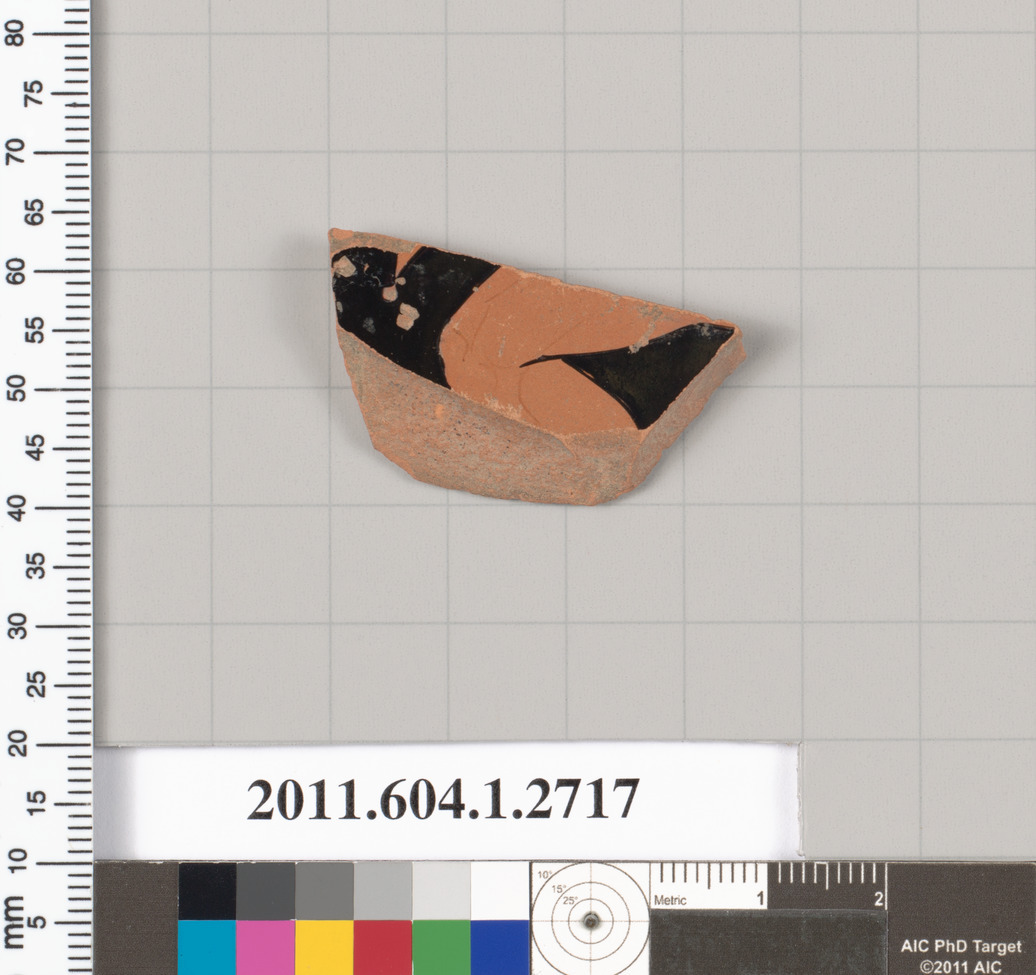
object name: kylix fragment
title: Terracotta fragment of a kylix (drinking cup)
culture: greek, attic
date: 490-480 BCE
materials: terracotta